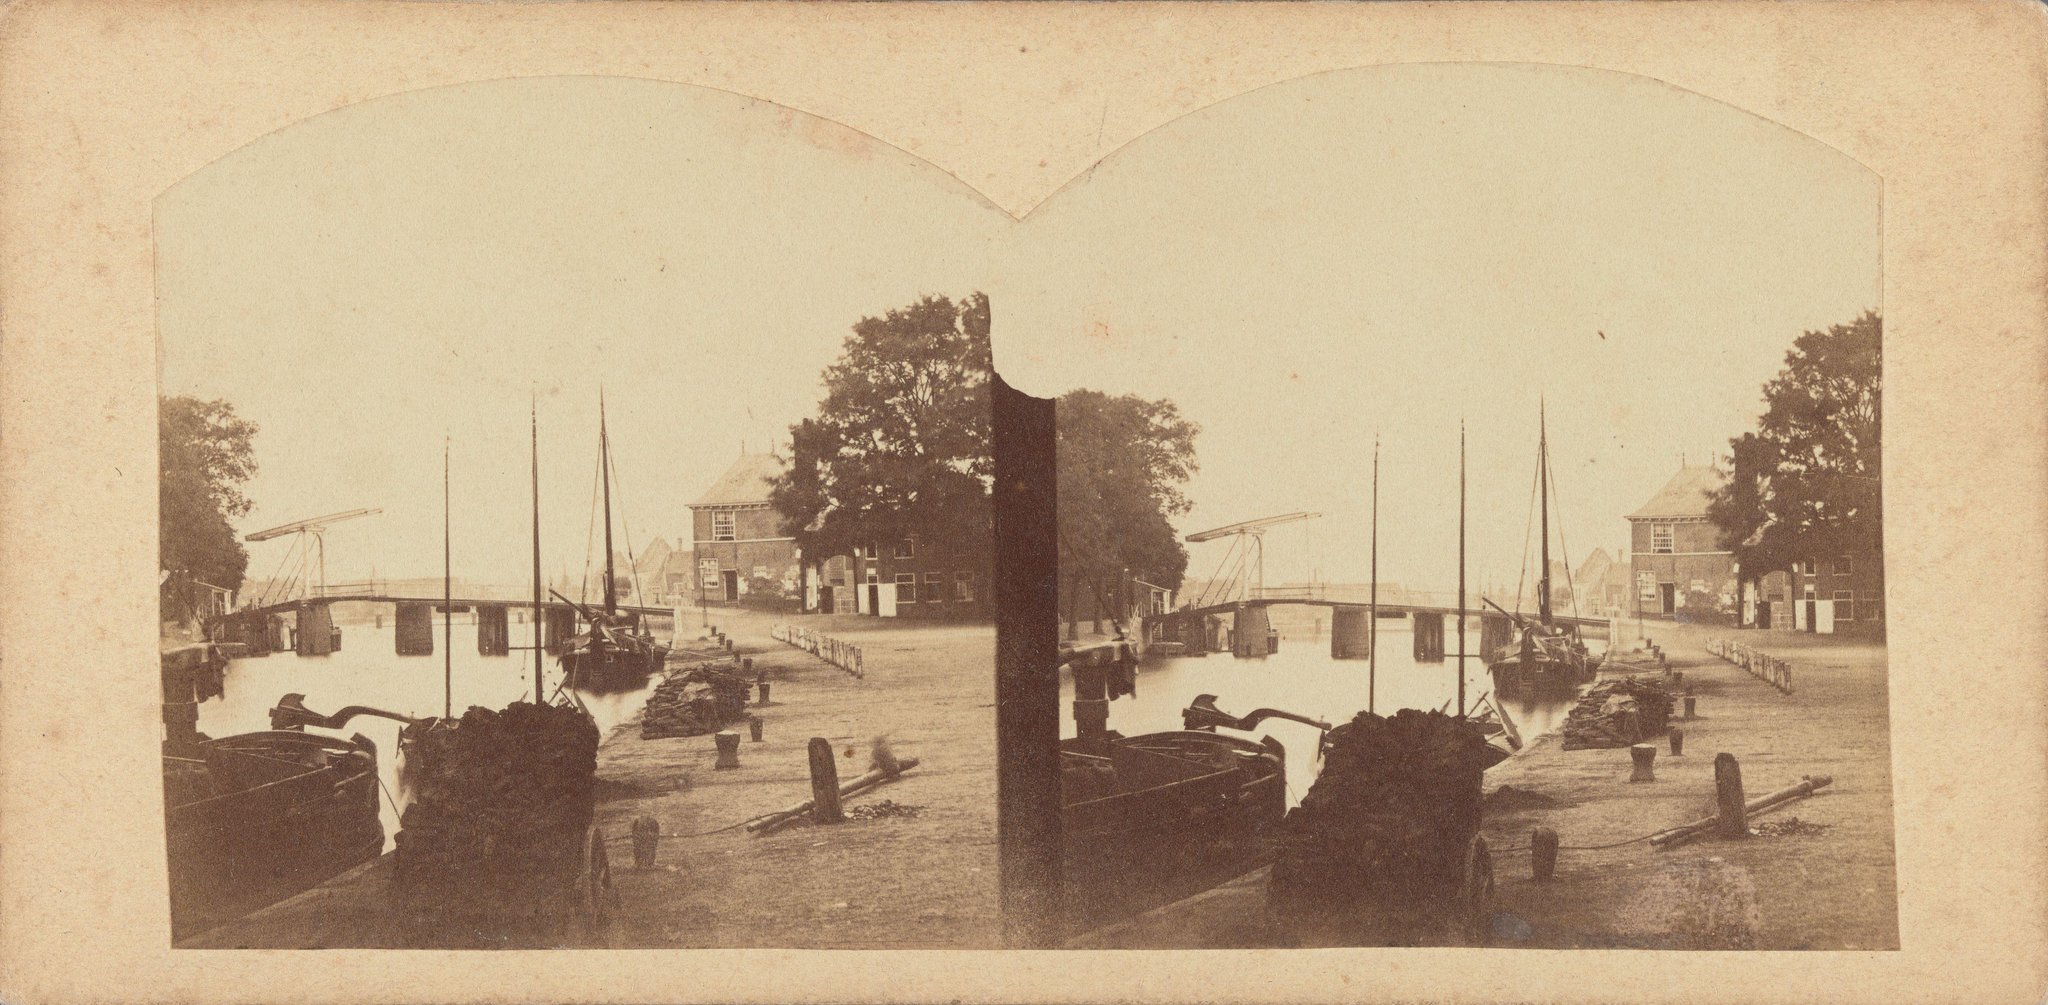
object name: stereograph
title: Gezicht op de Turfmarkt in Haarlem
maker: Anonymous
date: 1860-1870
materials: cardboard, paper, photographic support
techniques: albumen print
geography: haarlem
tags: pier, quay, wharf, bridge in city across river, canal, etc., haarlem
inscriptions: inscription: ‘Turfmarkt Haarlem.’